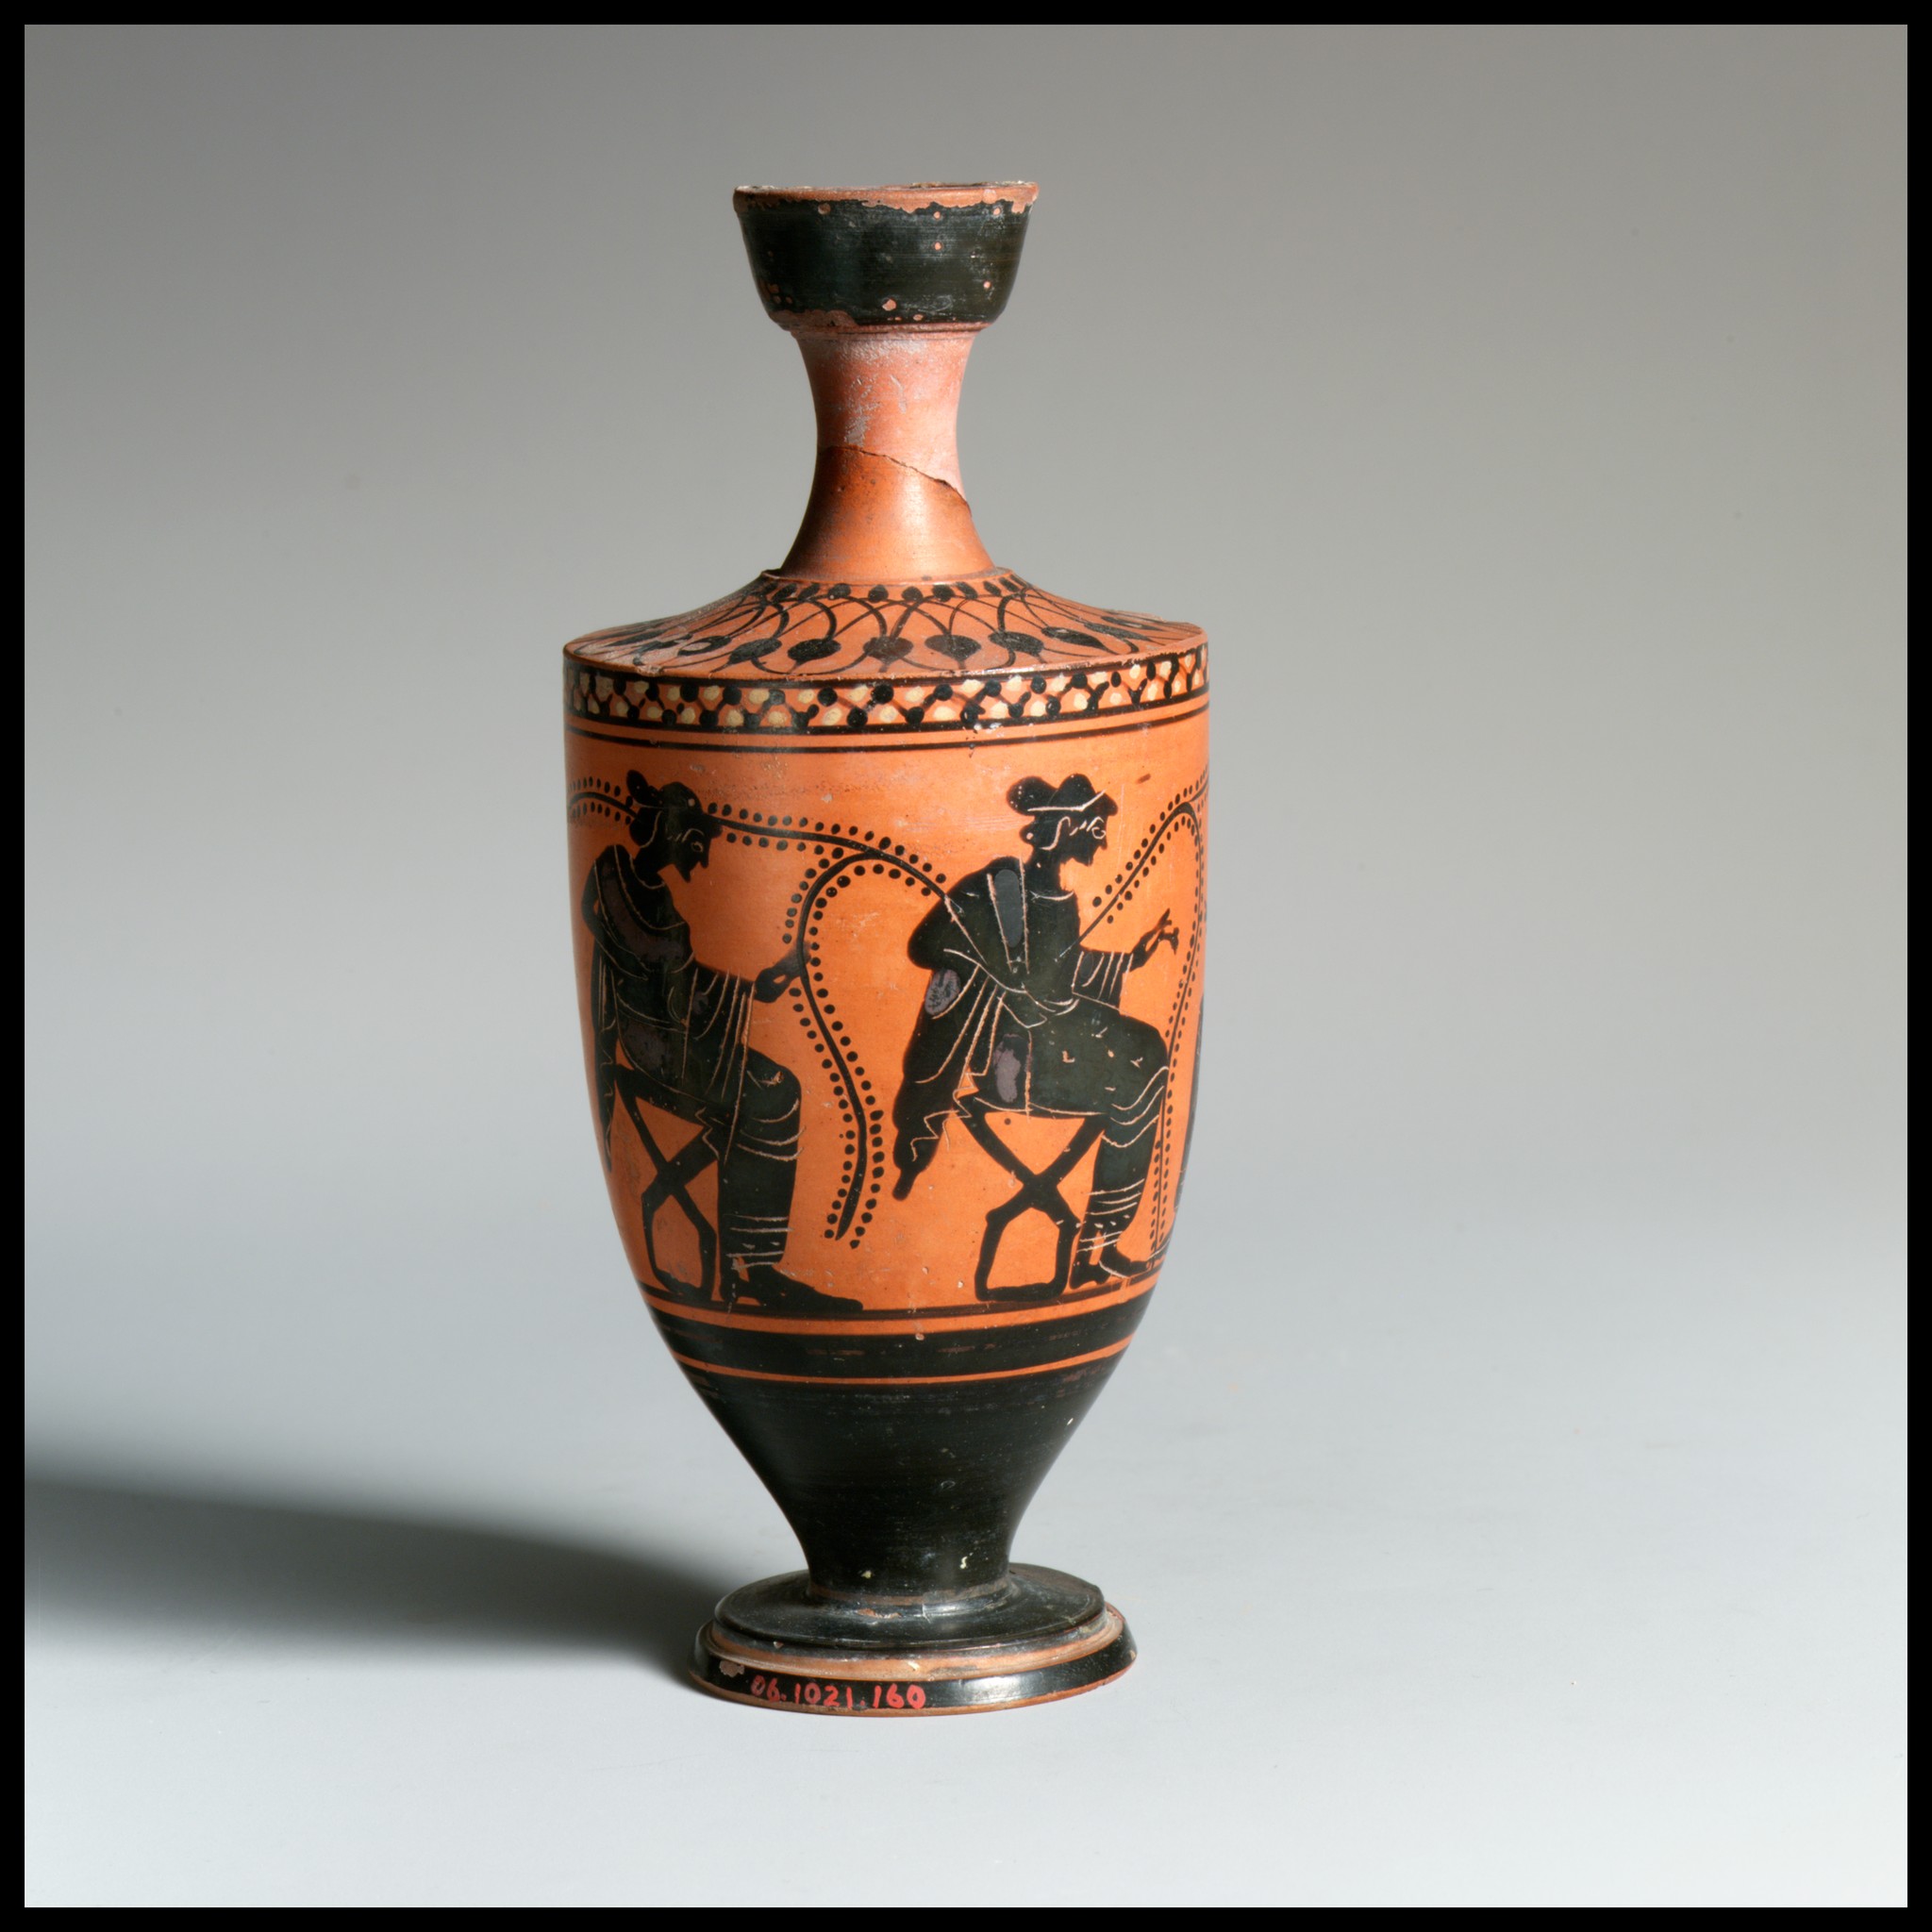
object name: lekythos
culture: greek, attic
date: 500 BCE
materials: terracotta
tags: women